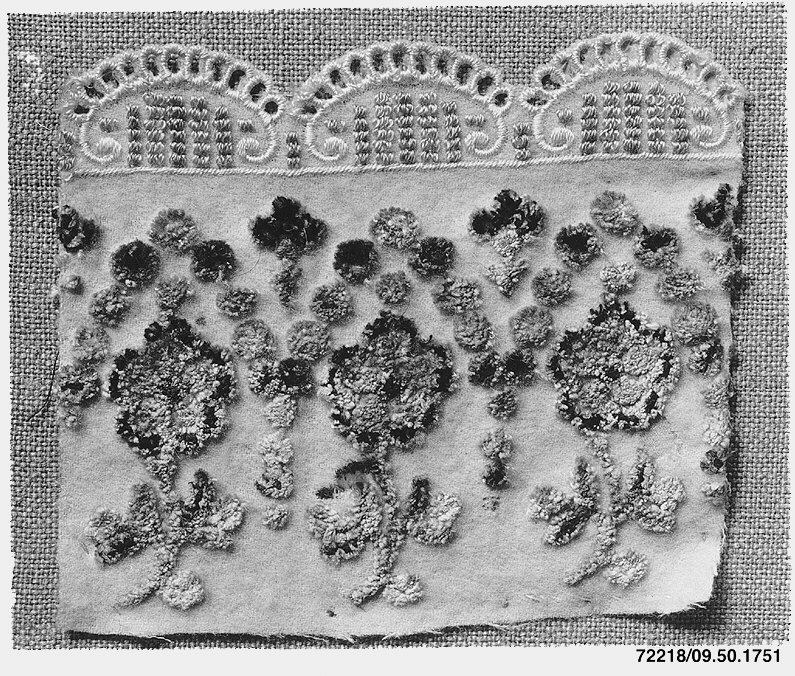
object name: fragment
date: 1801-1900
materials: silk